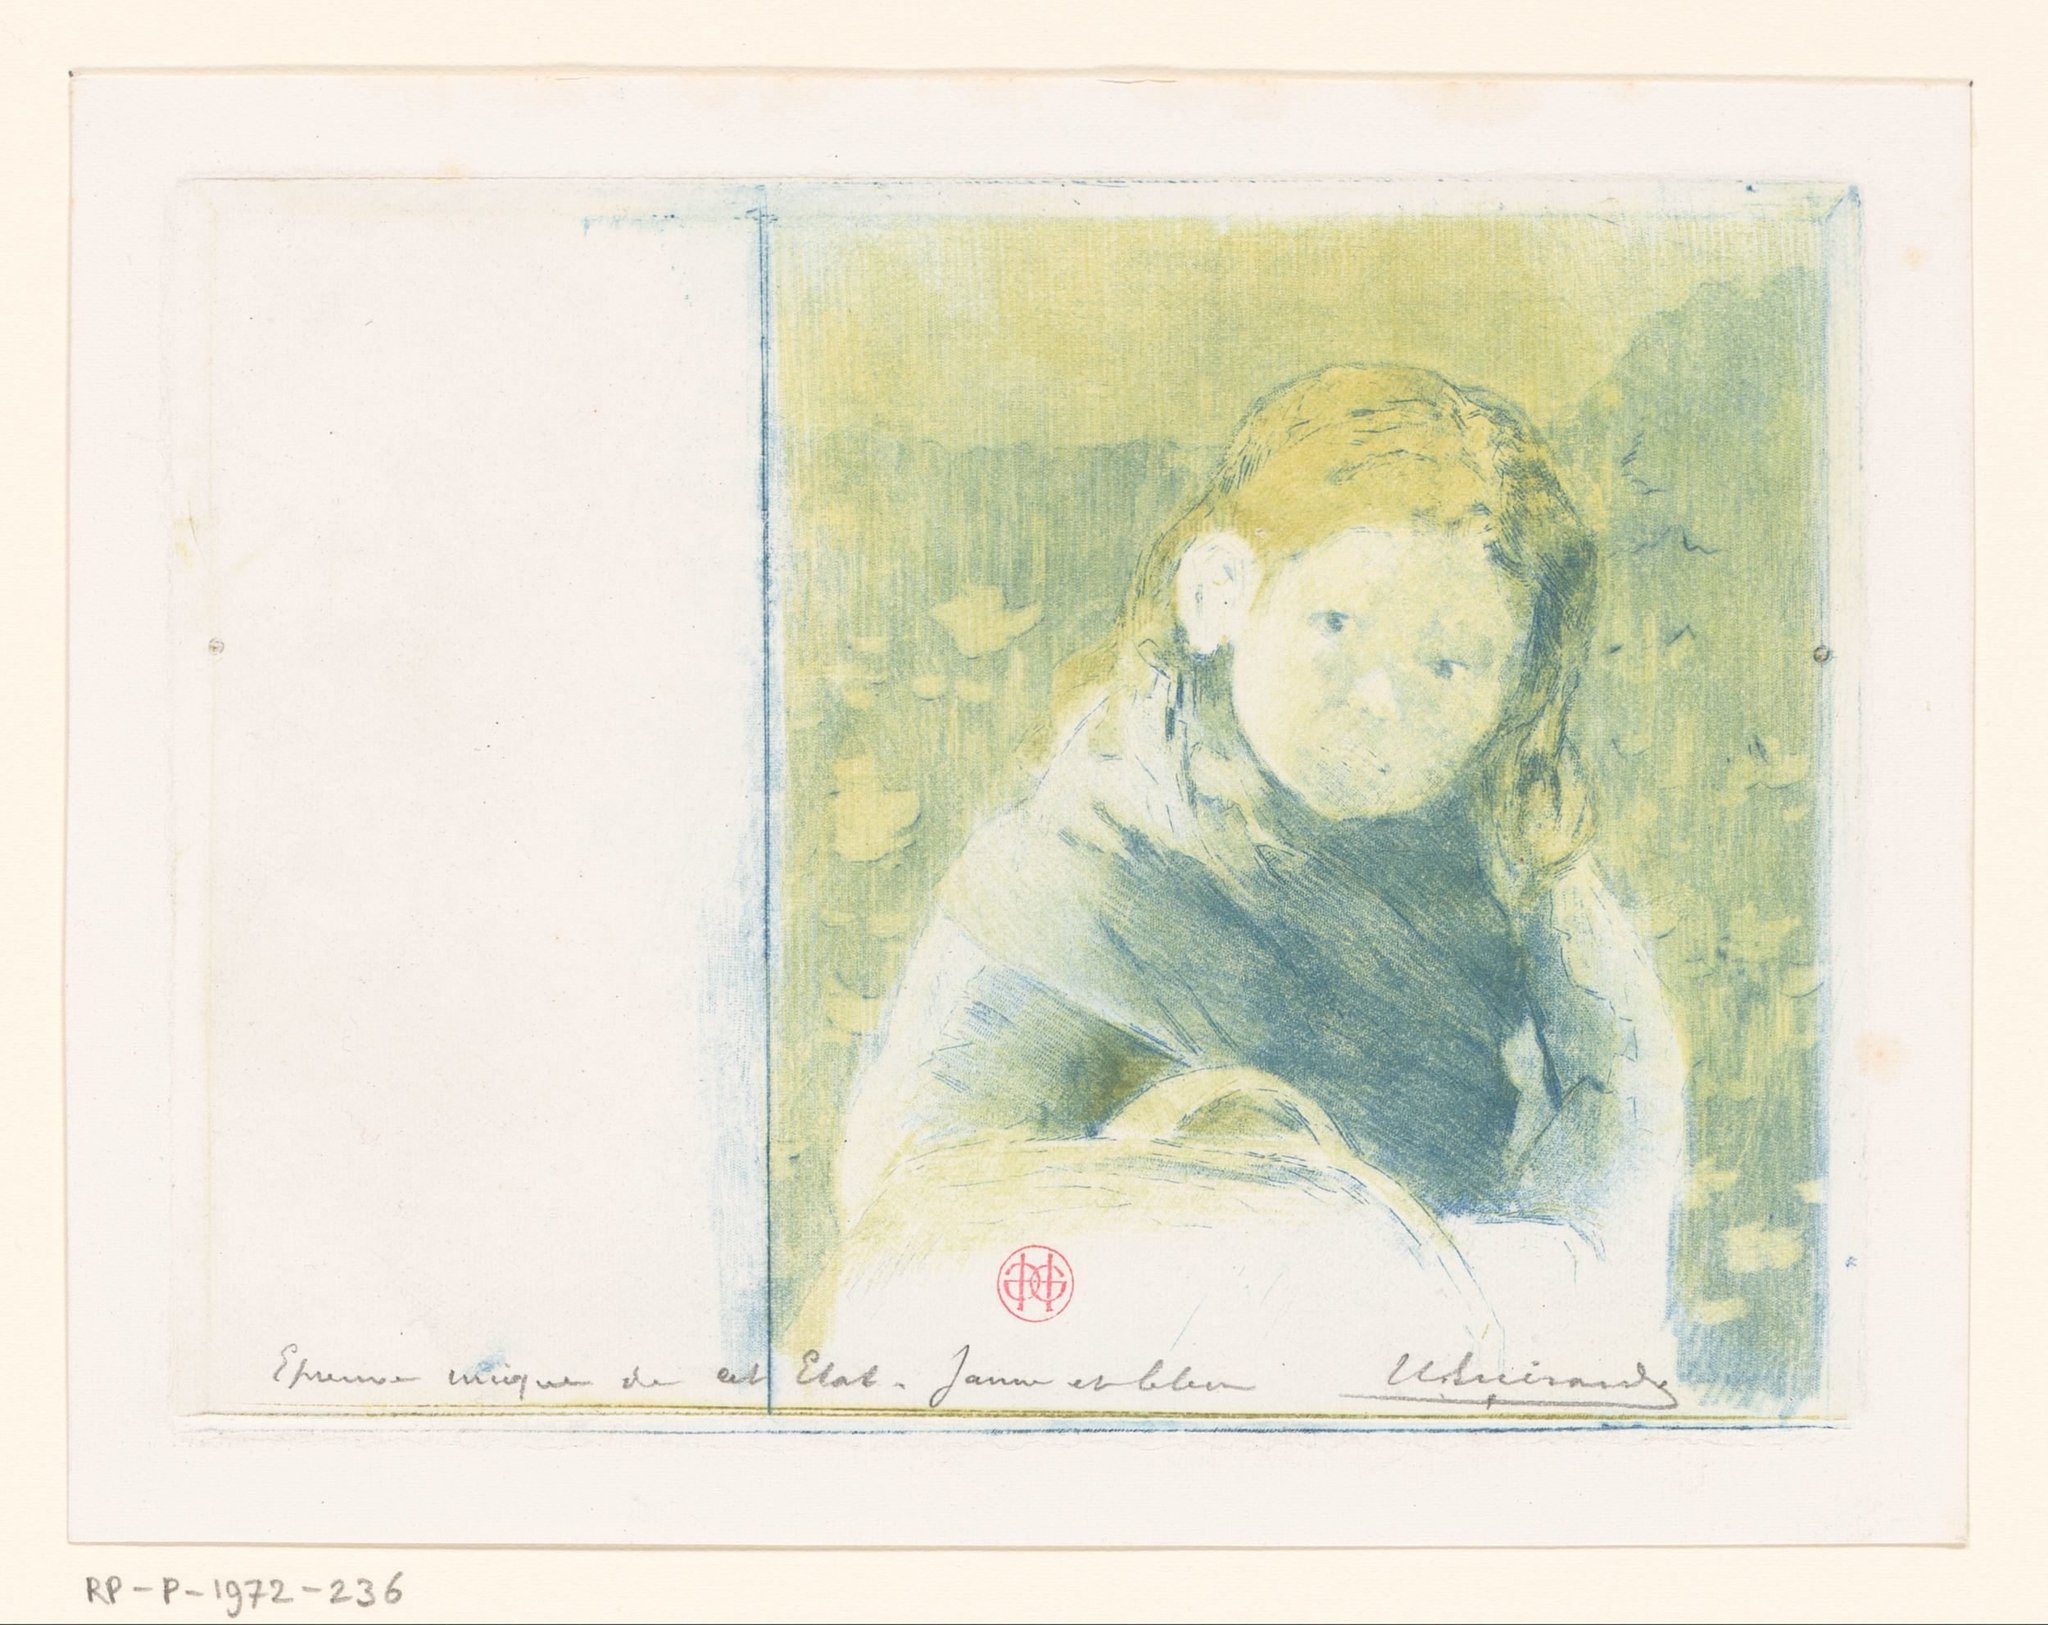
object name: print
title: Meisje met mand in een bloemenweide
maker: henri charles guérard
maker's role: print maker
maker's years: 1846-1897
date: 1856-1897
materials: paper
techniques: roulette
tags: meadow, pasture, container made of plant material other than wood: basket, girl (child between toddler and youth)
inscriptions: collector's mark: Lugt 2760, collector's mark: Lugt 2228, stamp: Lugt 1157, annotation: ‘Epreuve unique de [...] Etat. Jaune et bleu’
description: Het Rijksmuseum beschikt over negentien drukken van dezelfde voorstelling (RP-P-1972-234 t/m RP-P-1972-252) in verschillende staten en tonen.